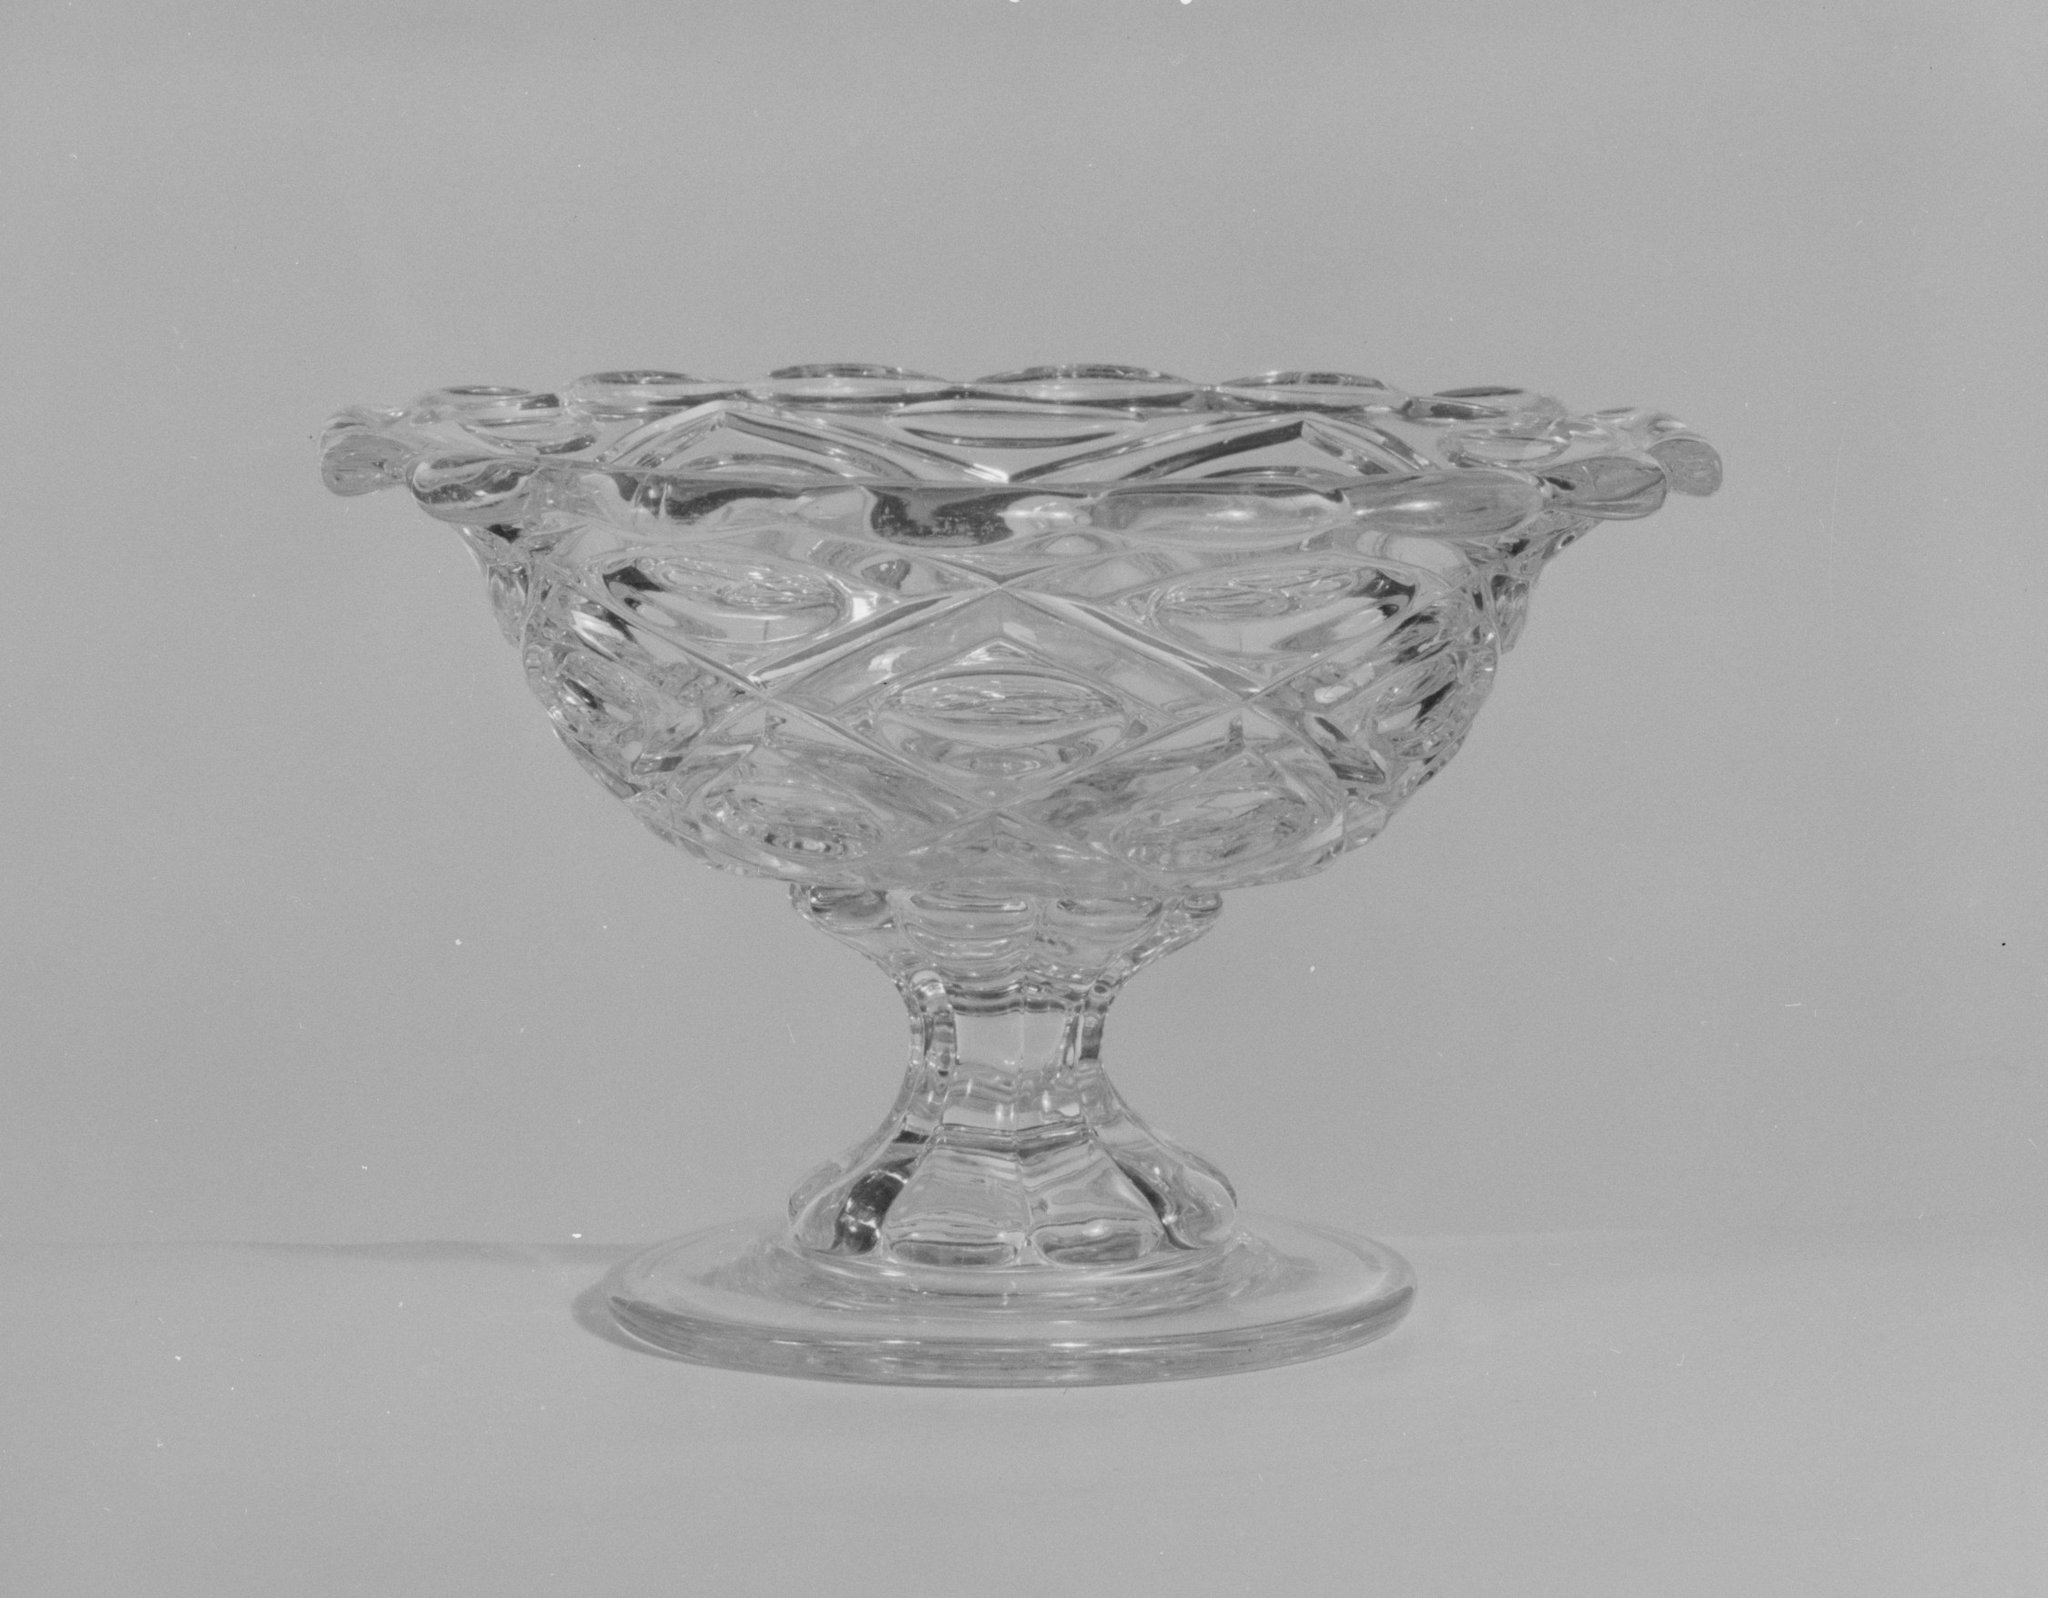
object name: bowl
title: Footed Bowl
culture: american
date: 1850-1870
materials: glass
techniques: pressed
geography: united states